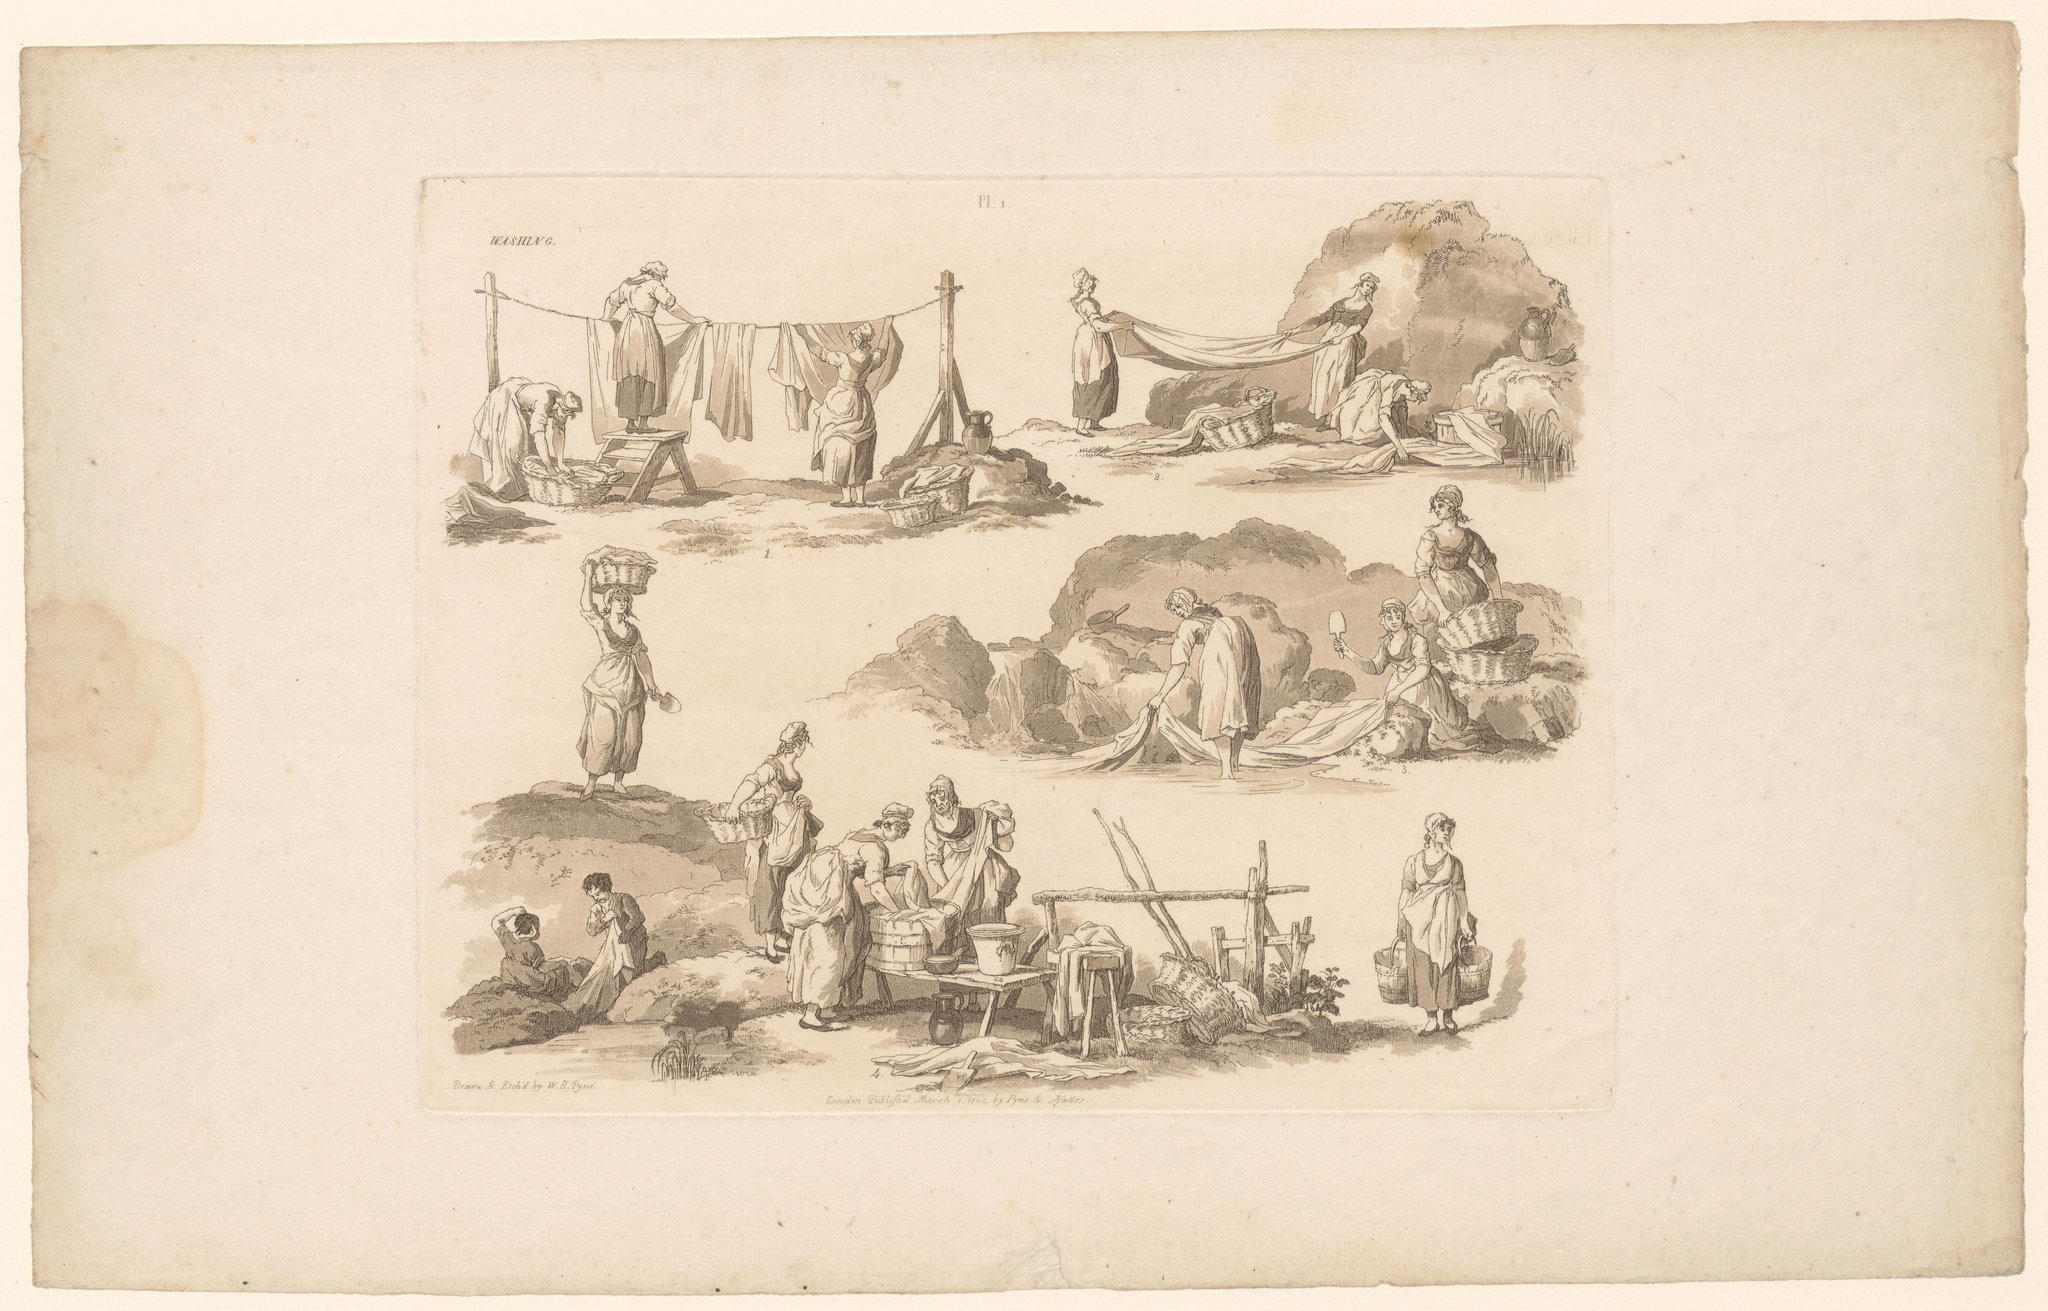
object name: print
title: Washing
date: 1802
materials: paper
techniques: aquatint, etching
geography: london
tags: laundering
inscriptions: collector's mark: Lugt 2228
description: Prent gebruikt in: Pyne, William Henry. Microcosm: or, a picturesque delineation of the arts, agriculture, manufactures, &c. of Great Britain. Londen: William Henry Pyne & John Claude Nattes, 1806.